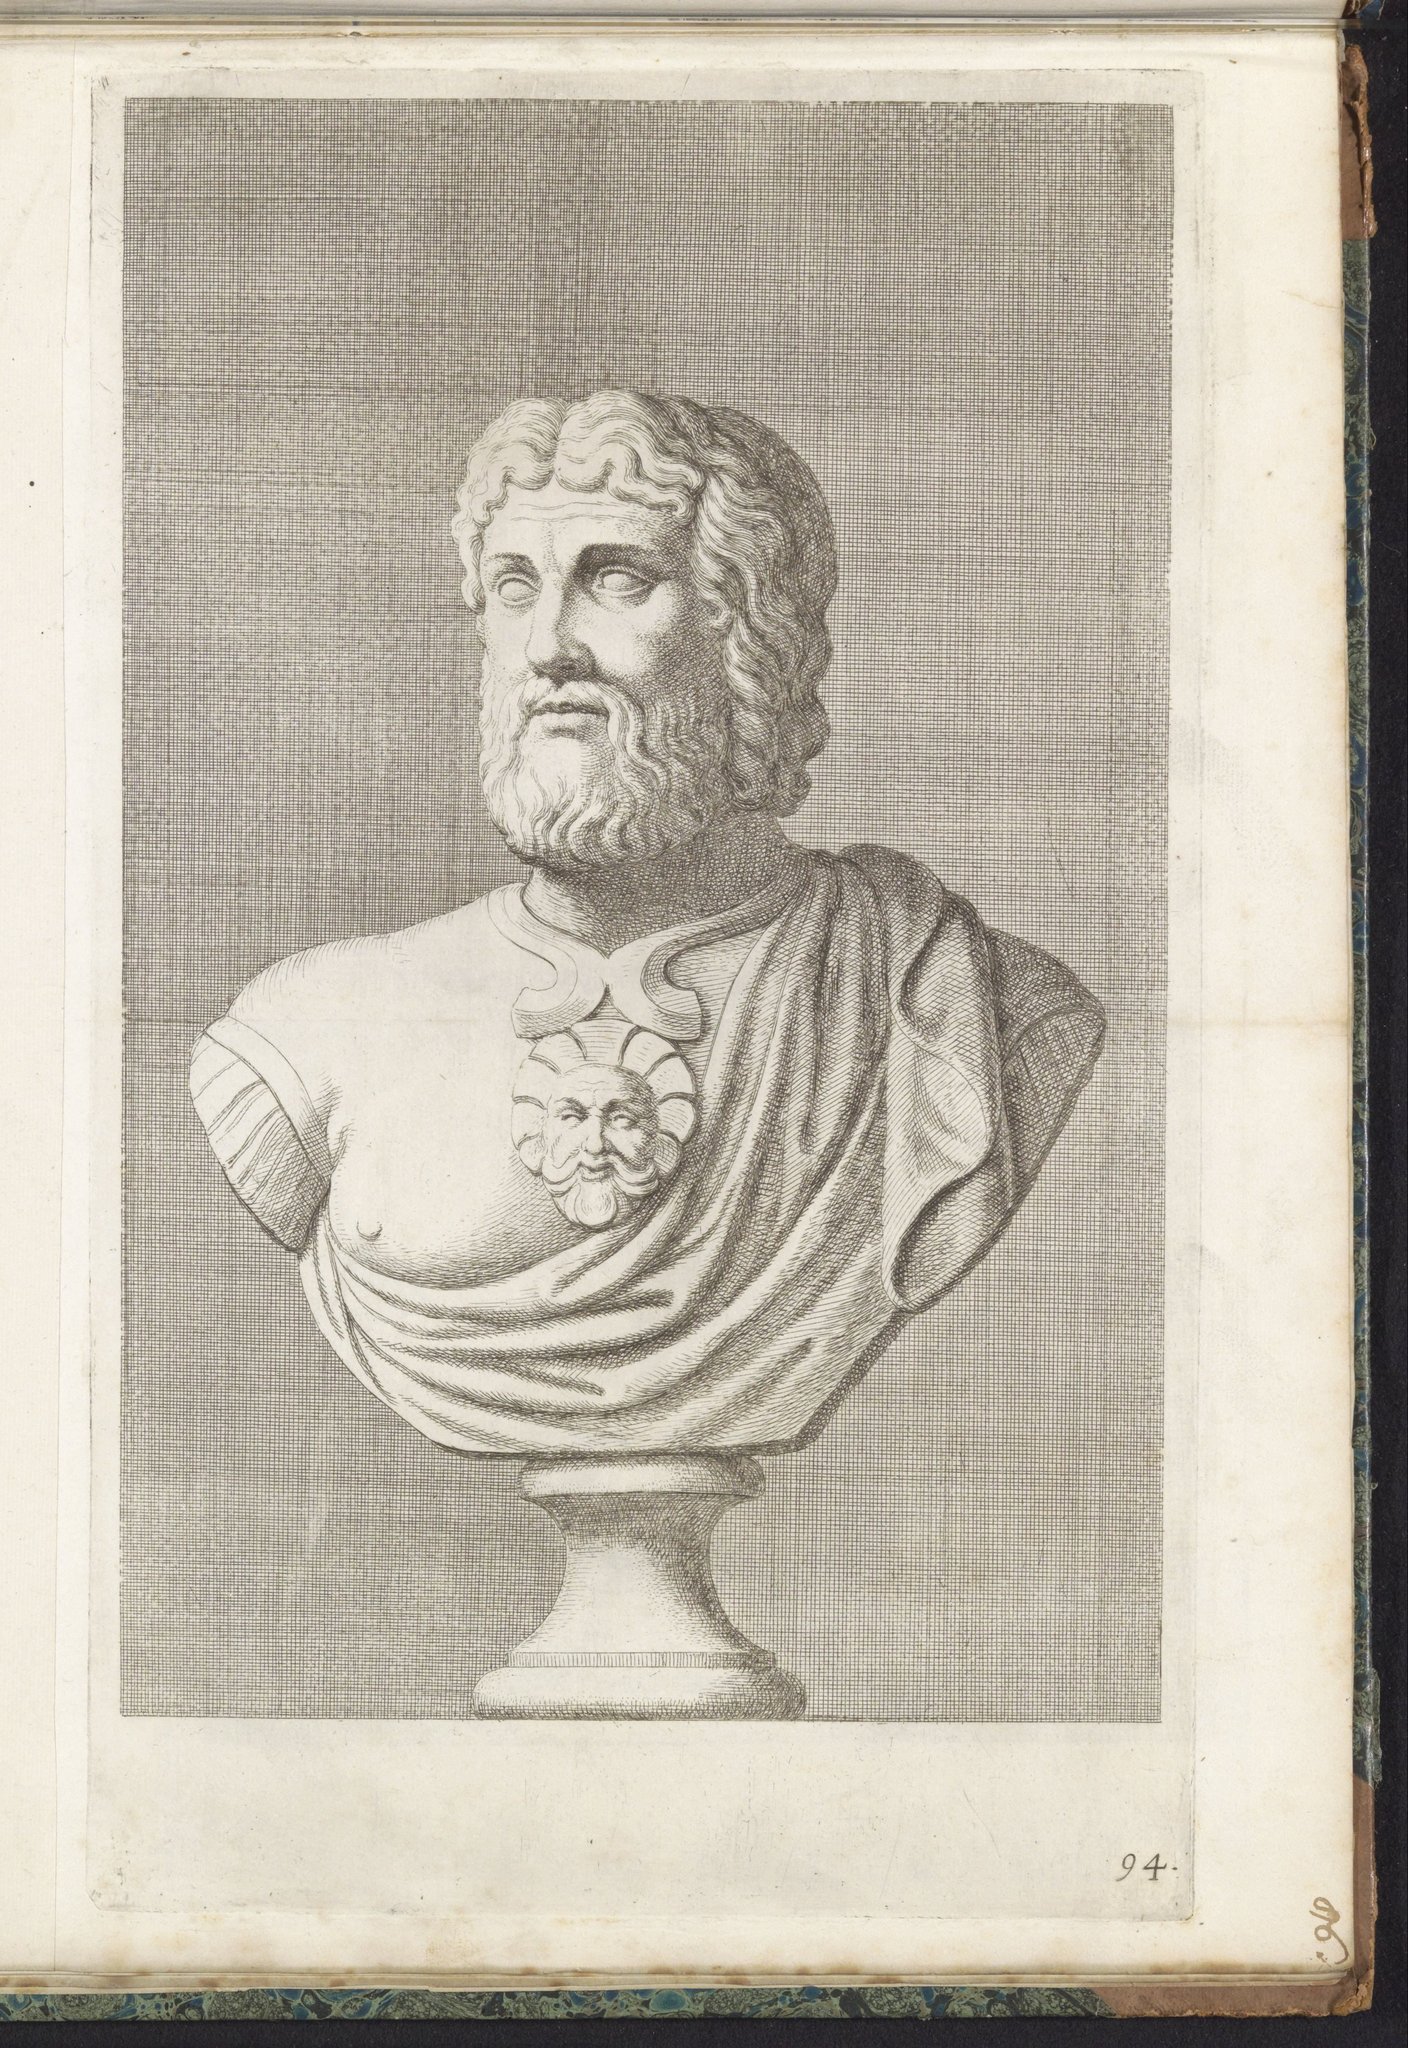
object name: album leaf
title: Buste van een bebaarde man, naar links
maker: hubert quellinus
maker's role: print maker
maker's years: 1619-1687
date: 1646-1670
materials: paper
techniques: engraving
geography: antwerp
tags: piece of sculpture, reproduction of a piece of sculpture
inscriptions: number: ‘94’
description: De prent maakt deel uit van een album met een serie prenten naar de sculpturen in de verzameling van Gerard Reynst.